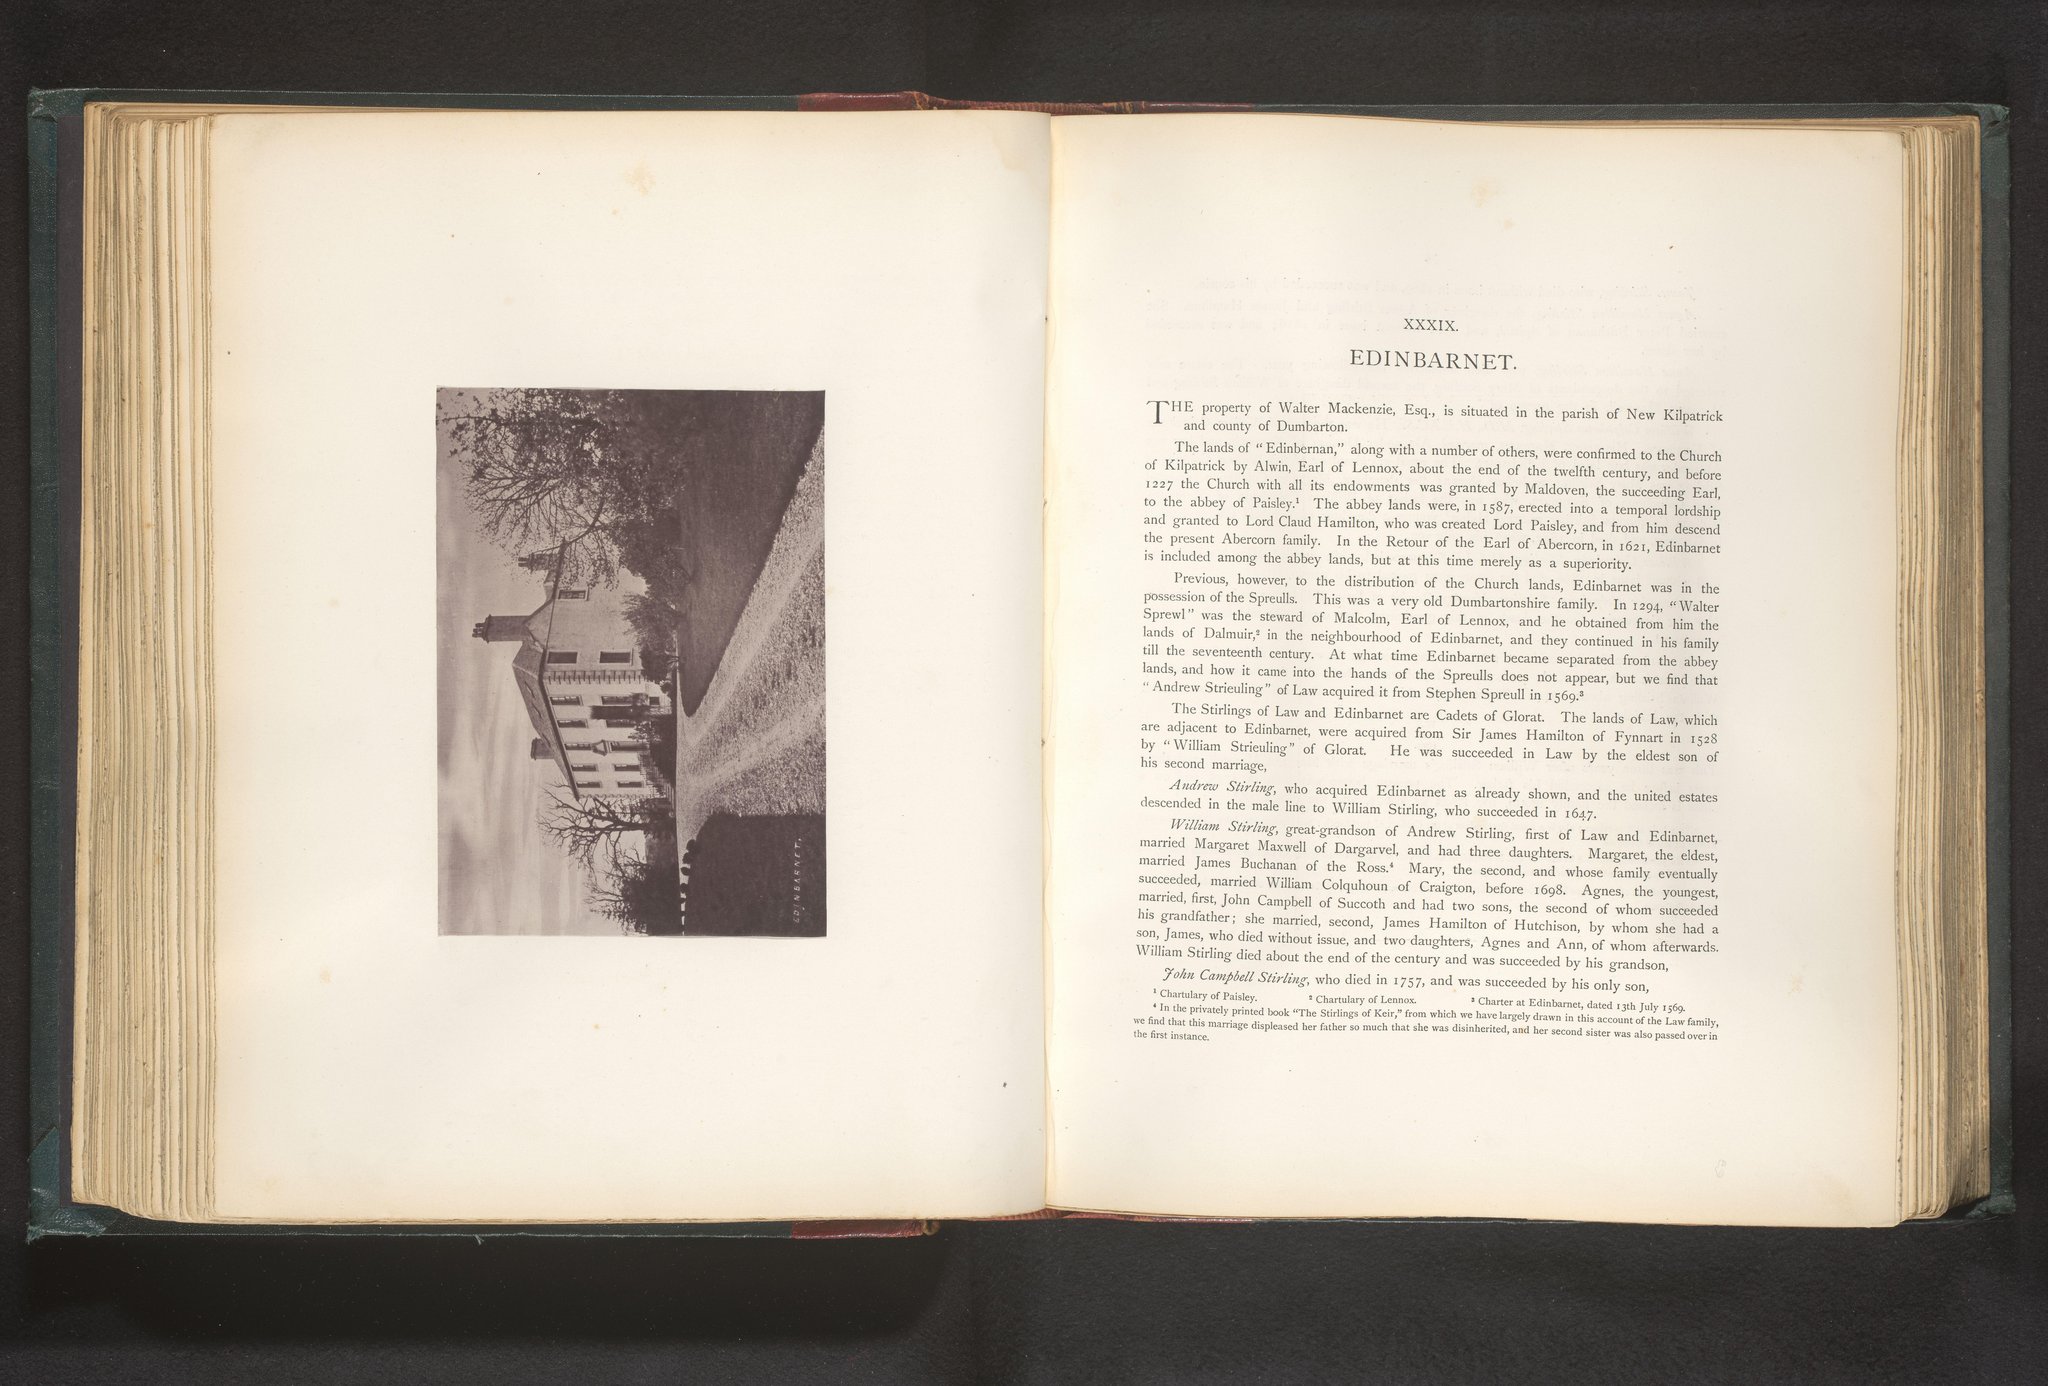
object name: page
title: Edinbarnet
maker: thomas annan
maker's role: fotograaf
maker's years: 1829-1887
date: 1868-1878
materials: paper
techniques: carbon print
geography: scotland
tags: rural housing, e.g. country-house, villa, cottage, façade (of house or building)